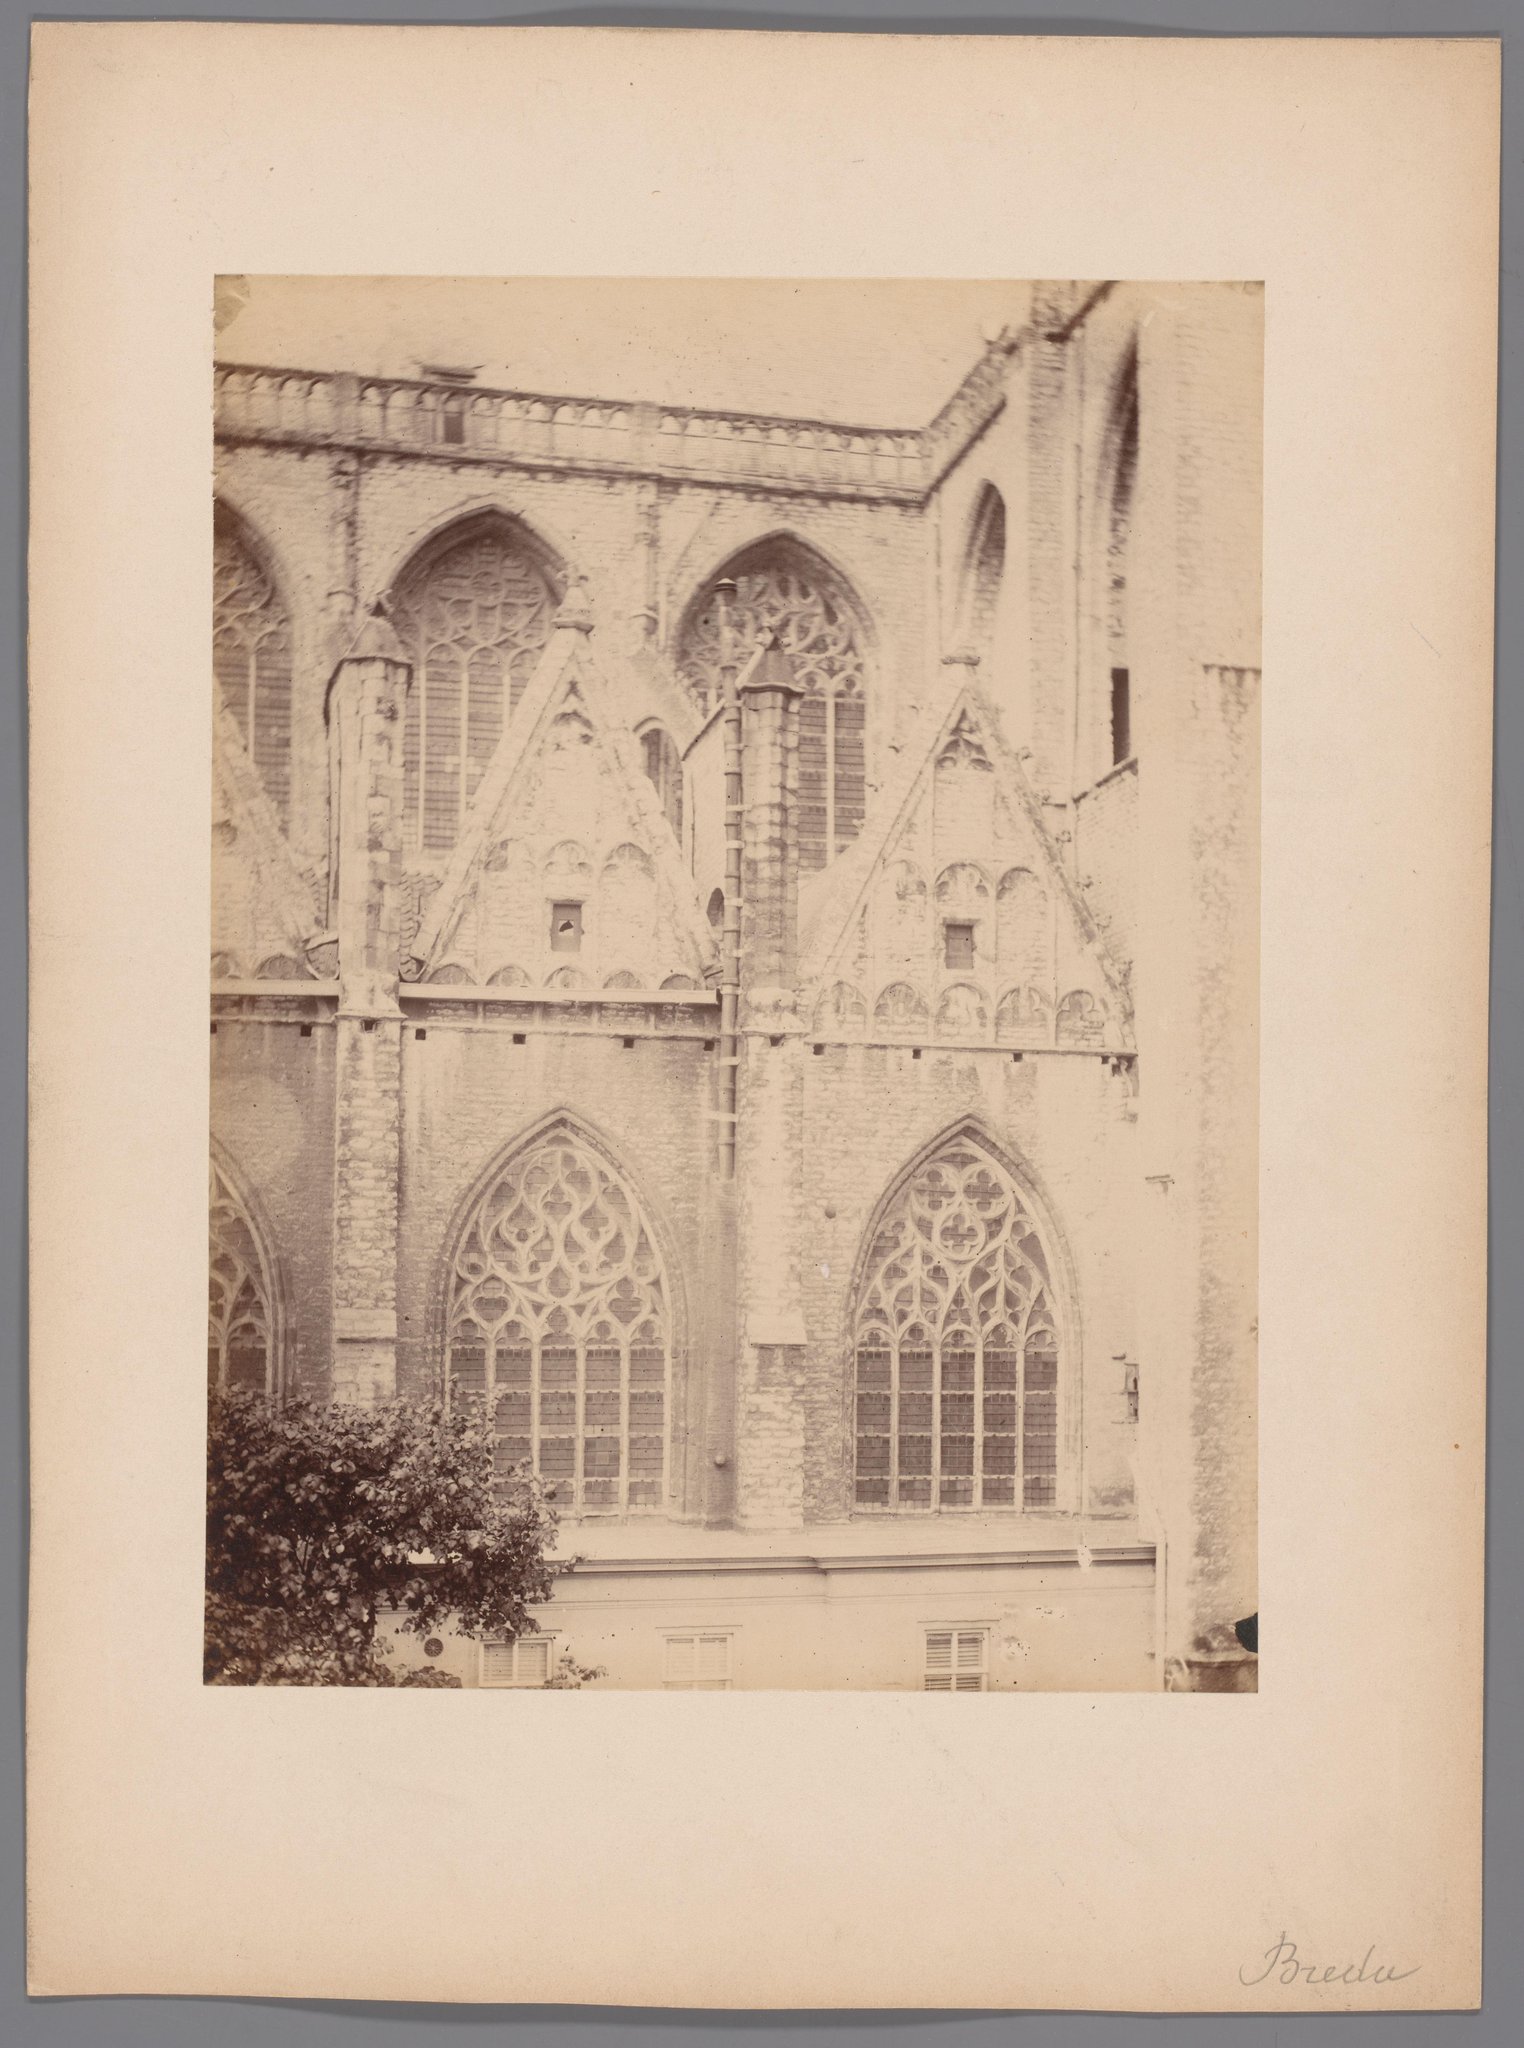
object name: photograph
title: Gedeelte van de Grote Kerk te Breda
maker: anoniem (monumentenzorg)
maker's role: fotograaf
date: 1890-1920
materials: cardboard, photographic support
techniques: albumen print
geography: breda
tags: church (exterior)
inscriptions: annotation: ‘N.H. Kerk te Breda/ Zuidzijde links van Transept’, annotation: ‘Breda’